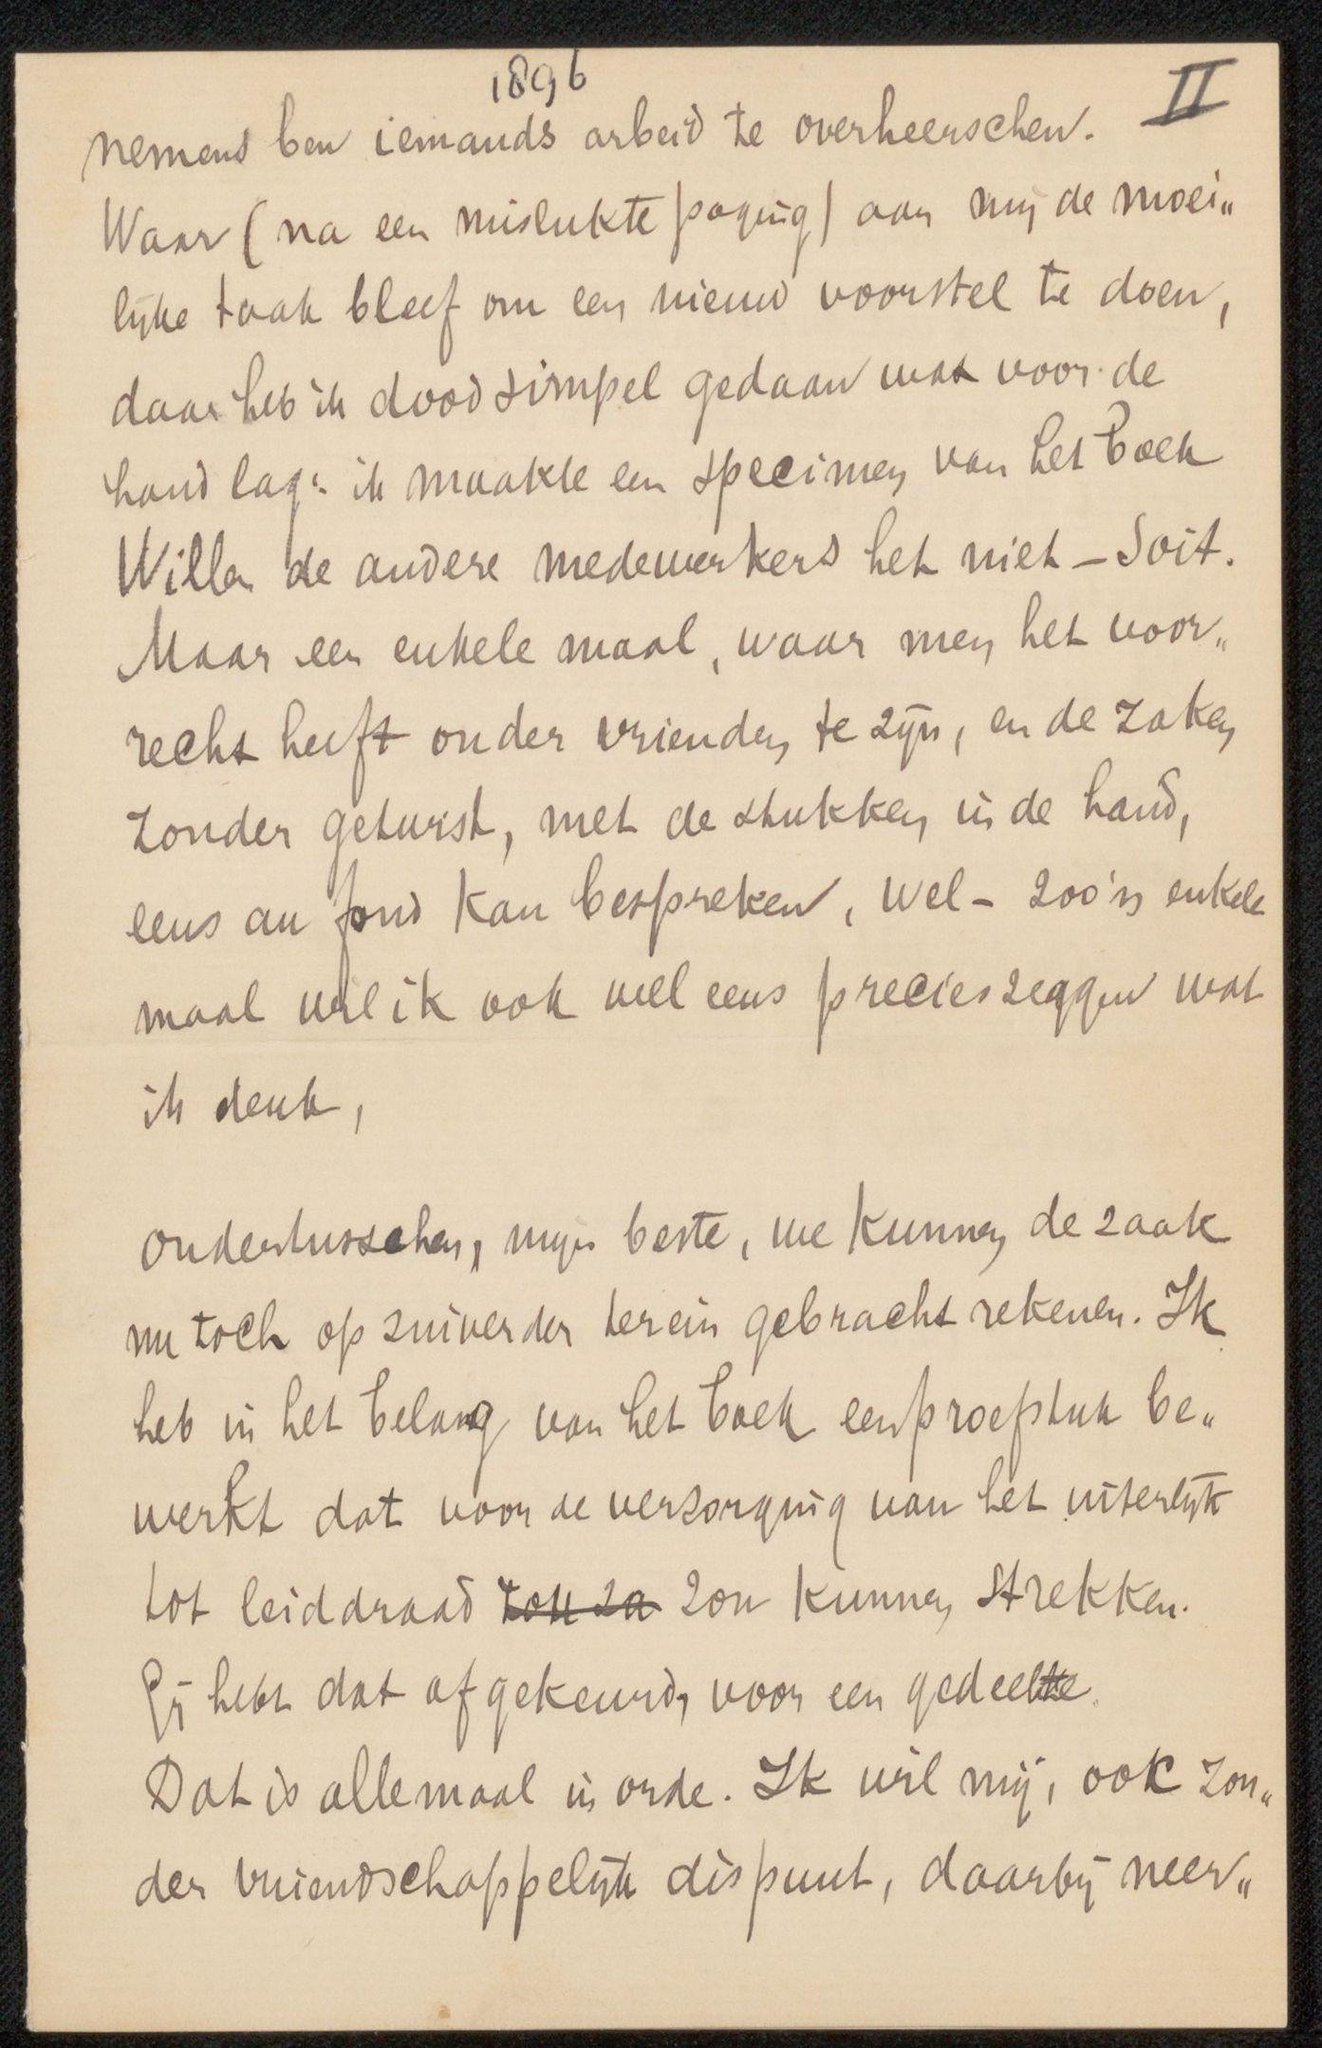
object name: letter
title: Brief aan Jan Veth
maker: antoon derkinderen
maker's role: draughtsman, painter, print maker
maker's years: 1859-1925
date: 1874-1925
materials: ink, paper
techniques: pen, writing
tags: cornelis marinus van gogh, dordrecht, painter, print maker, draughtsman, designer, jan veth, printed matter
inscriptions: collector's mark: ‘RPK’